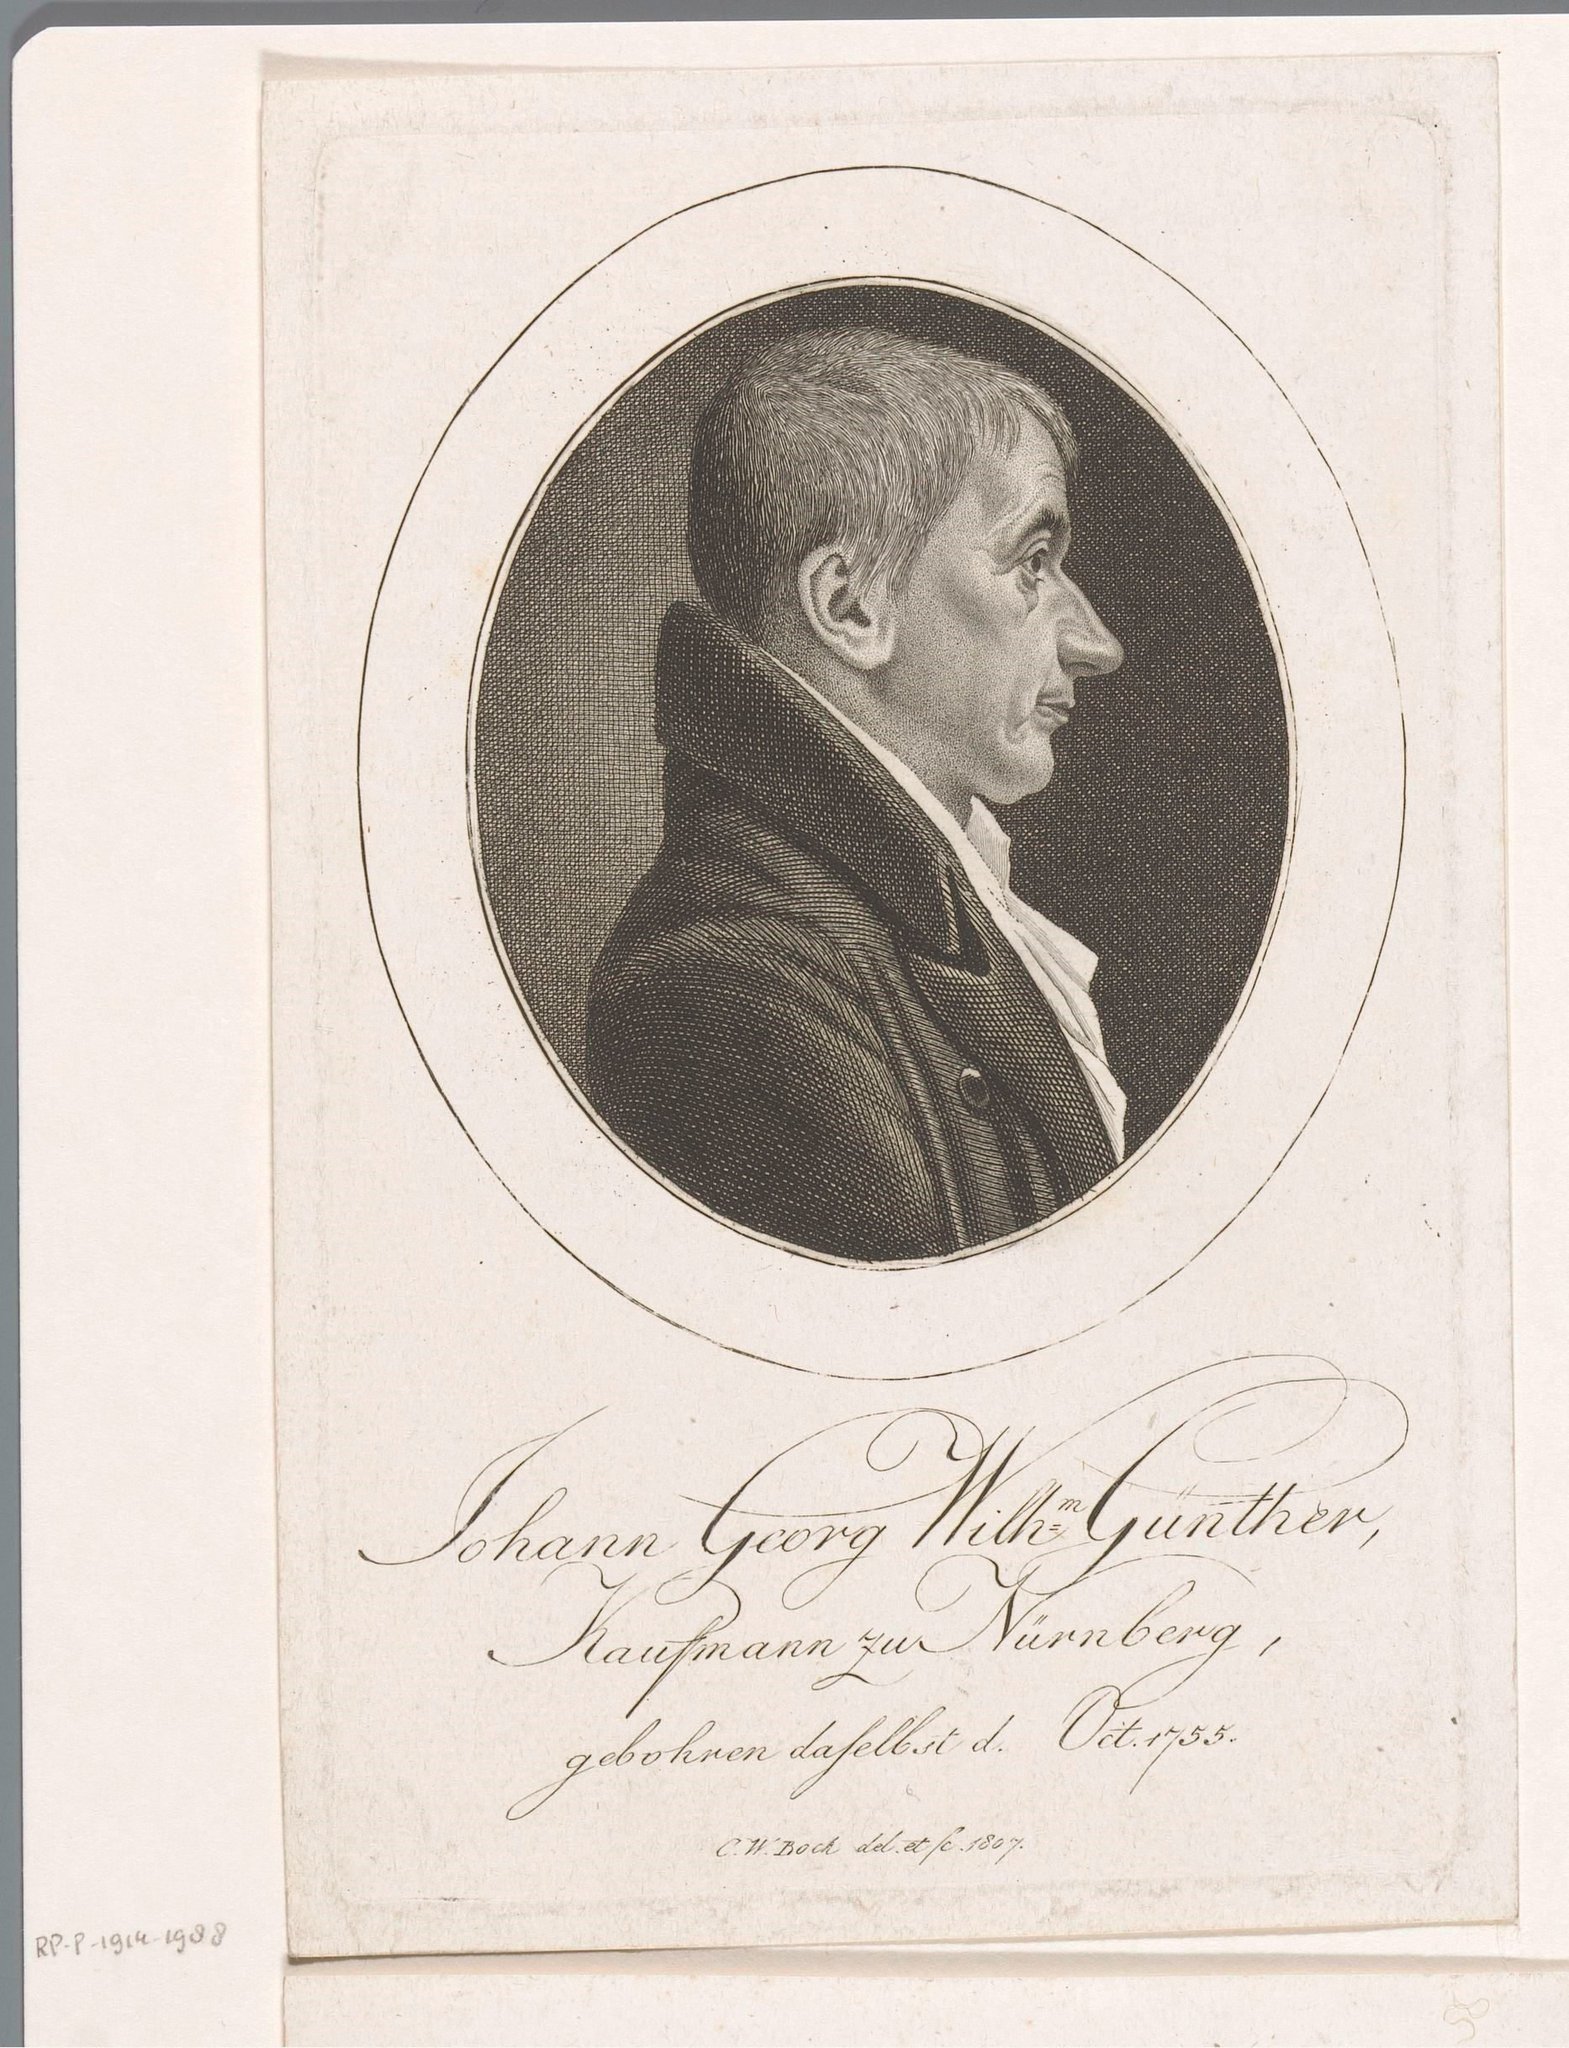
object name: print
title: Portret van Johann Georg Wilhelm Günther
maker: christoph wilhelm bock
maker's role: print maker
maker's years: 1755-1836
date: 1807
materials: paper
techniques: engraving, etching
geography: nuremberg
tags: historical persons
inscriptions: collector's mark: Lugt 2228